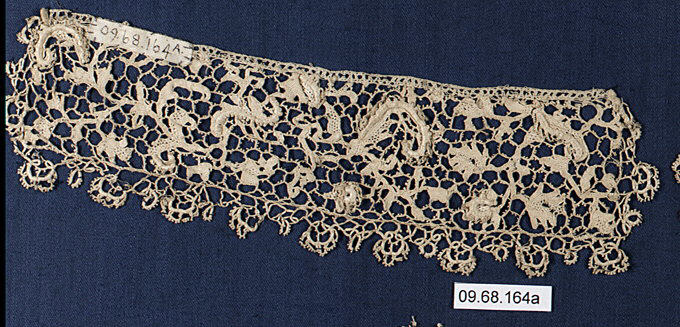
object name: cuff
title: Cuff (one of a pair)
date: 1667-1700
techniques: lace